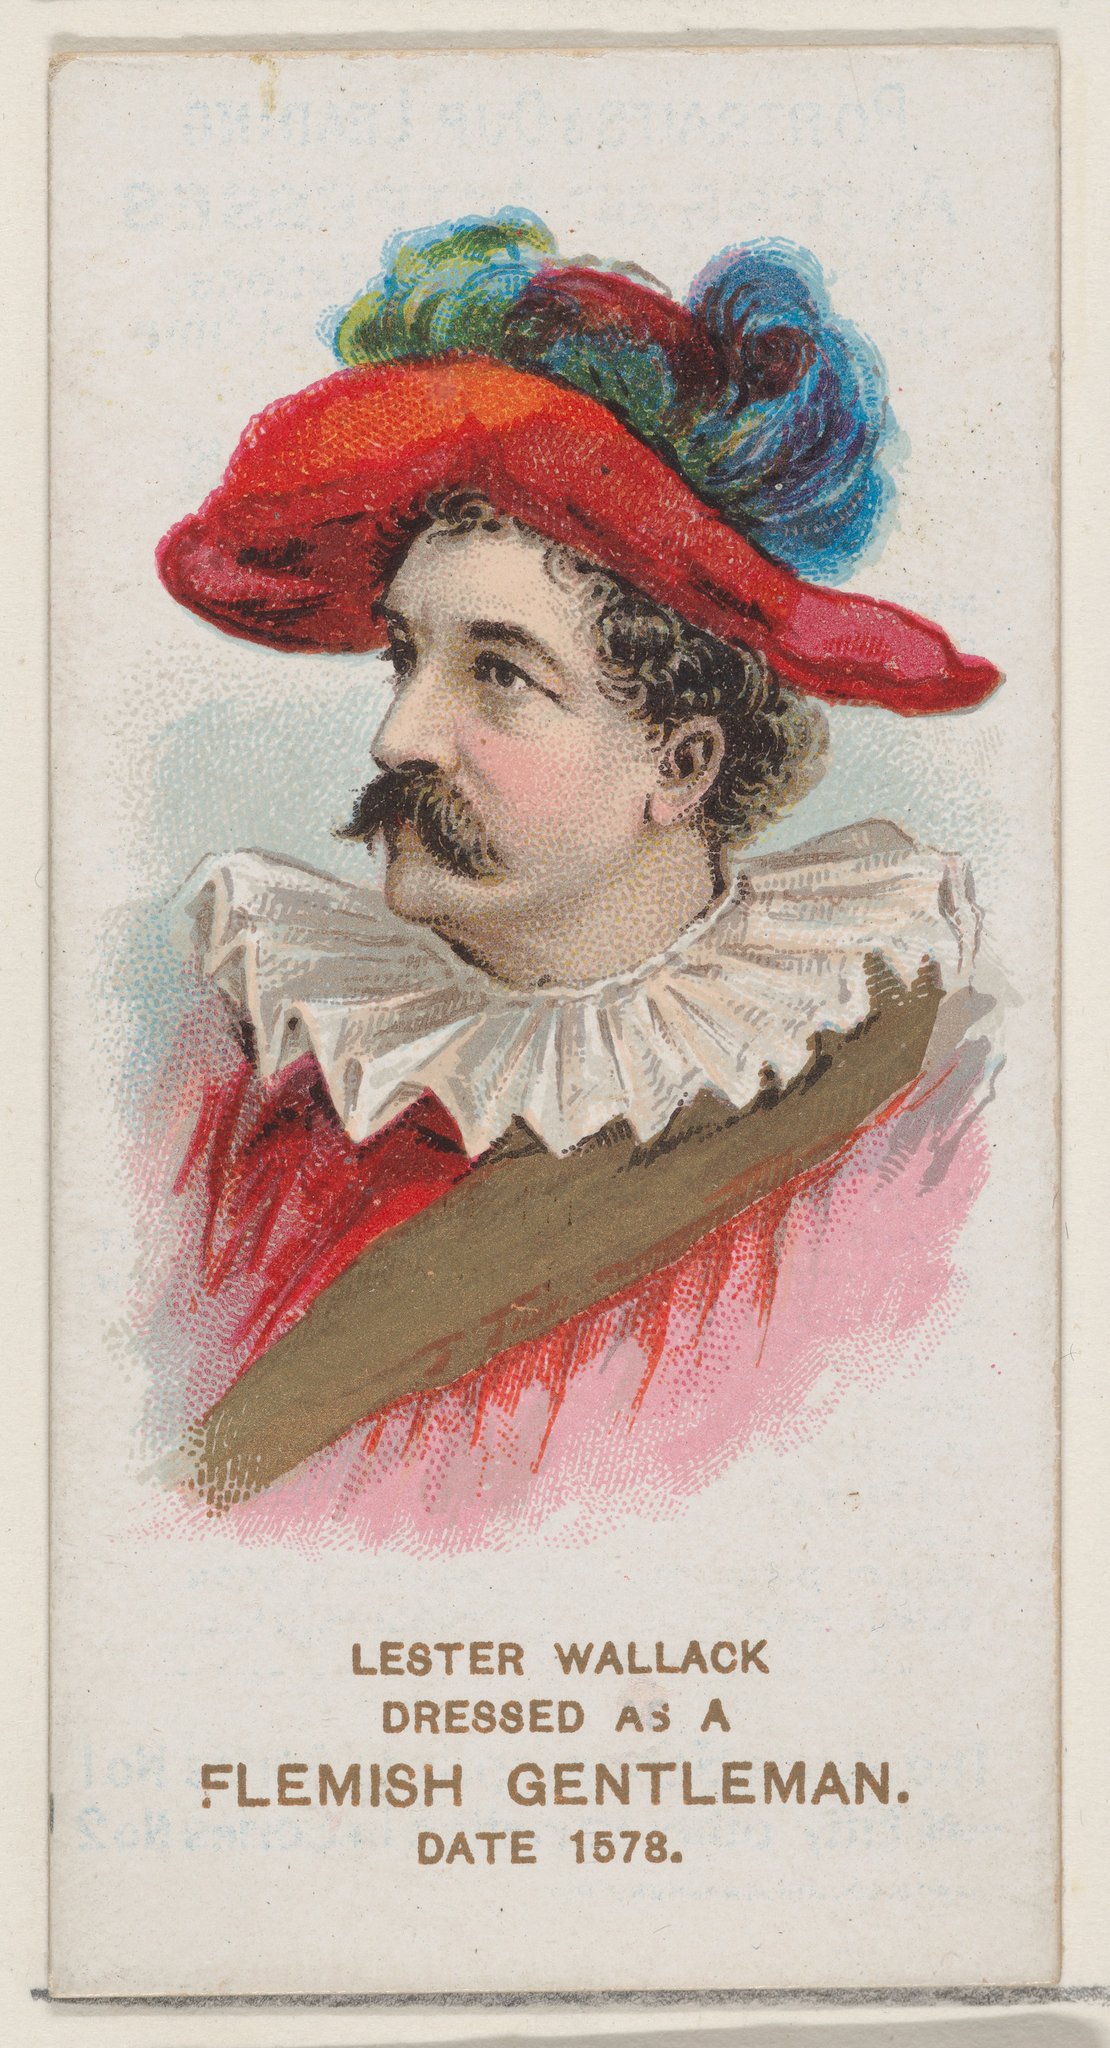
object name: print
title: Lester Wallack Dressed as a Flemish Gentleman of 1578, from the set Actors and Actresses, First Series (N70) for Duke brand cigarettes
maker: w. duke, sons & co.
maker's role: publisher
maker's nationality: american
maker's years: 1870-1920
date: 1888-1889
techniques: color lithograph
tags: men,actors